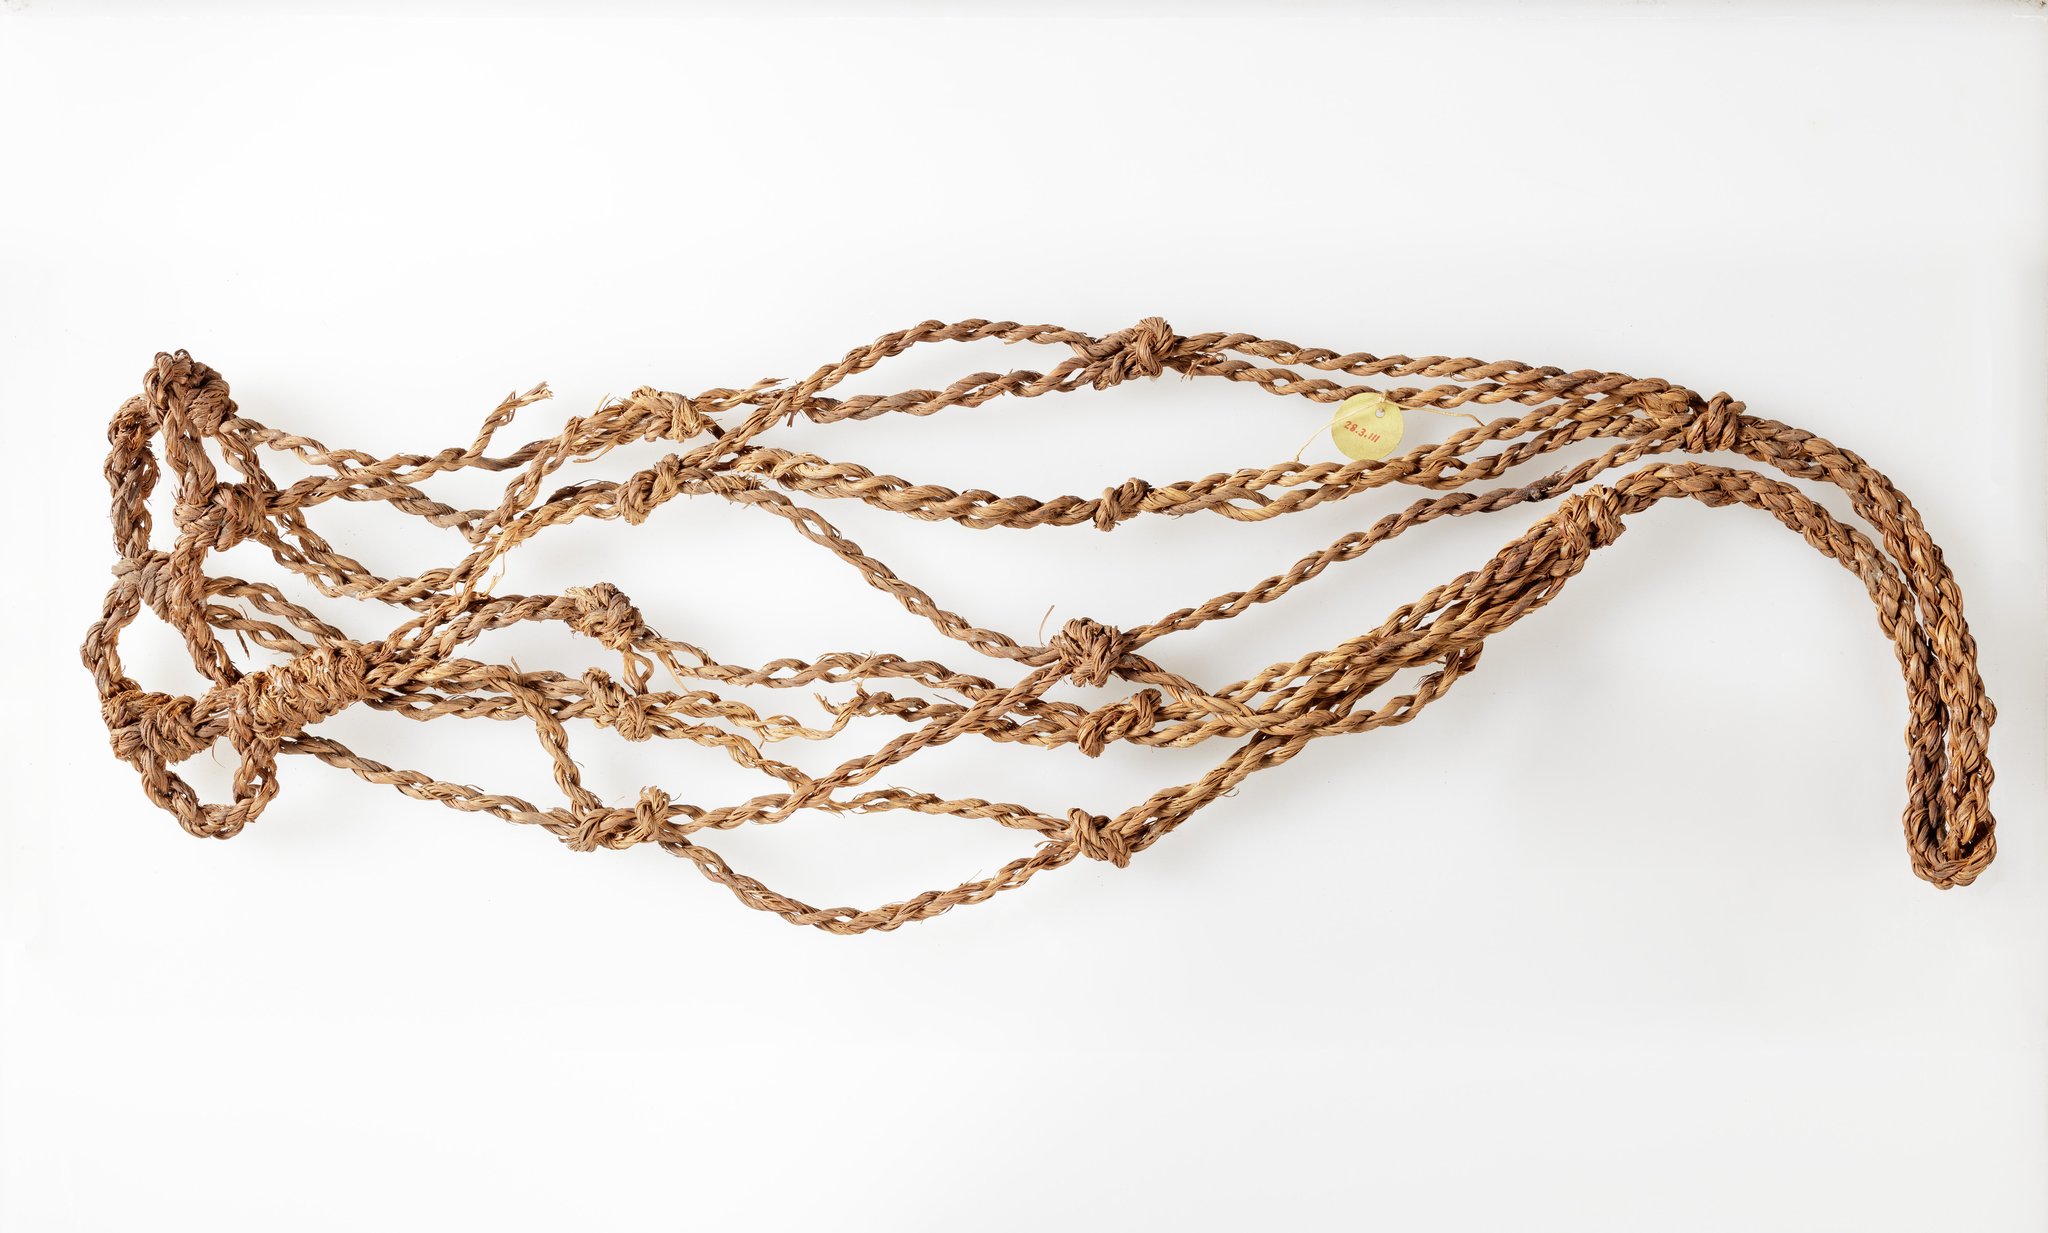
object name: pot sling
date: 945-525 BCE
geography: egypt